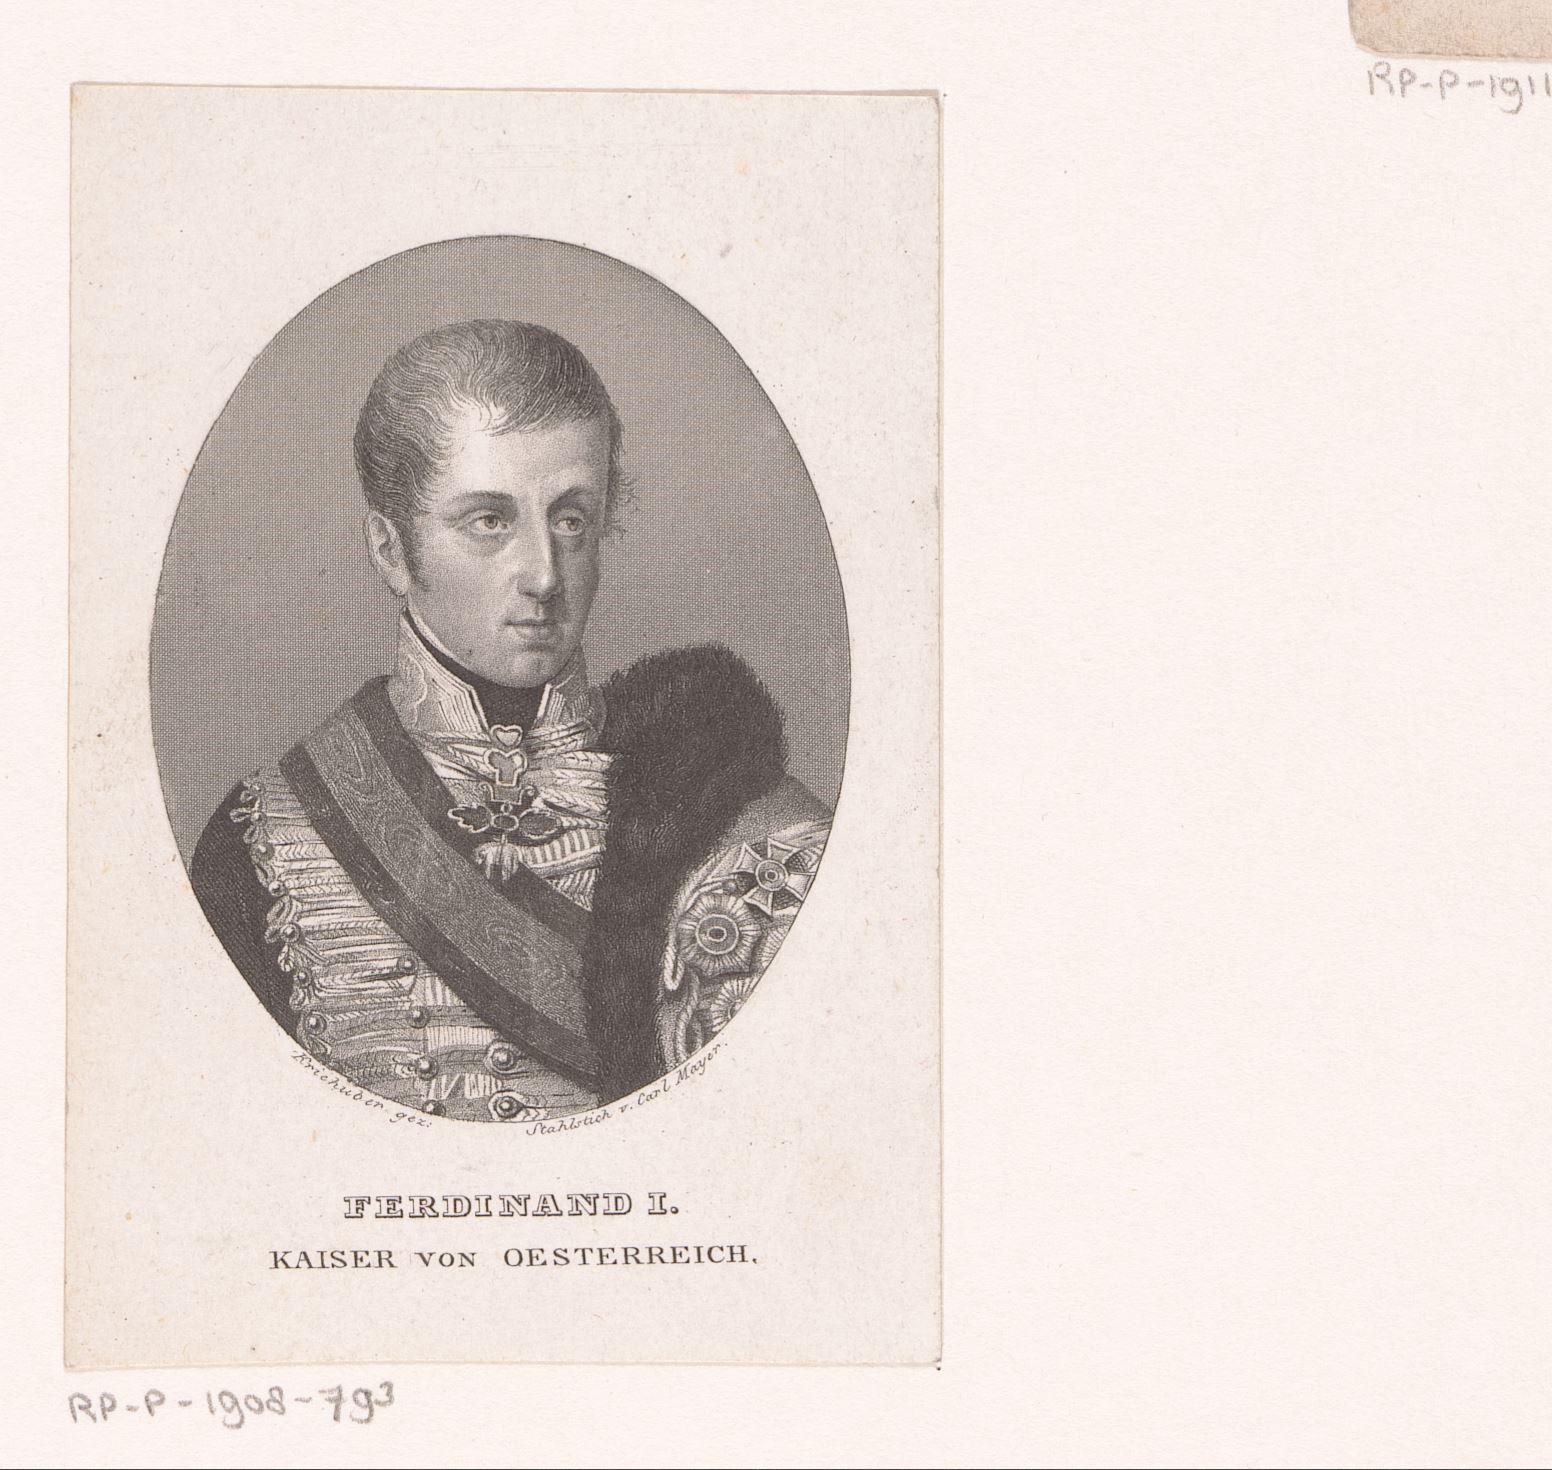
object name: print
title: Portret van Ferdinand I, keizer van Oostenrijk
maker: carl mayer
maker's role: print maker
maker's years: 1798-1868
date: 1808-1868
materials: paper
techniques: engraving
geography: nuremberg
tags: vienna, prague, ferdinand i (keizer van oostenrijk), historical persons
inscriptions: collector's mark: Lugt 2228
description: Vermoedelijk afkomstig uit: Almanach de Gotha.